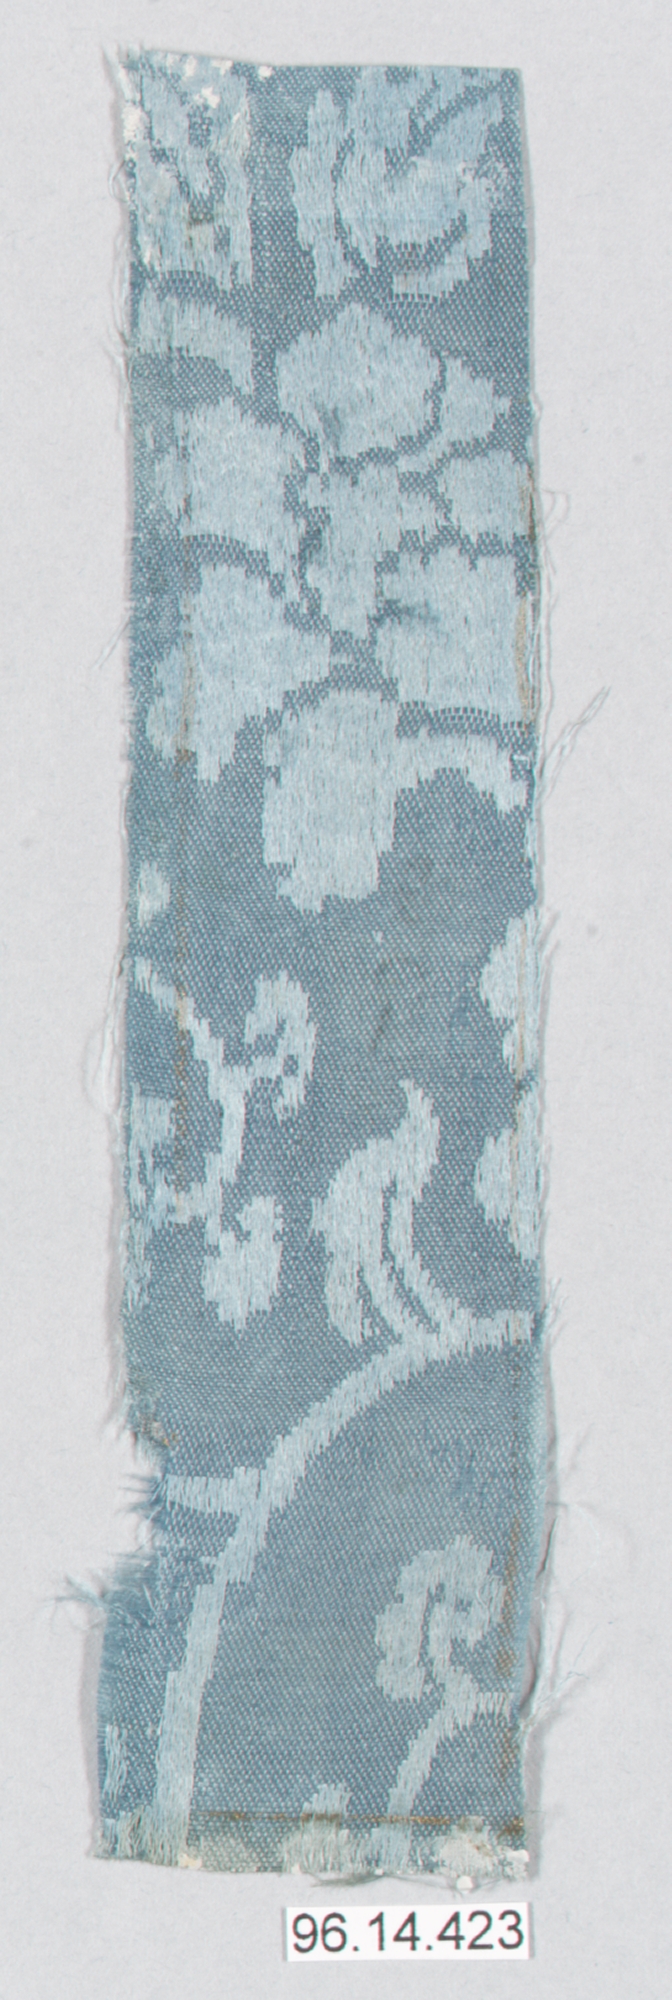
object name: piece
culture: japanese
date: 1701-1900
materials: silk